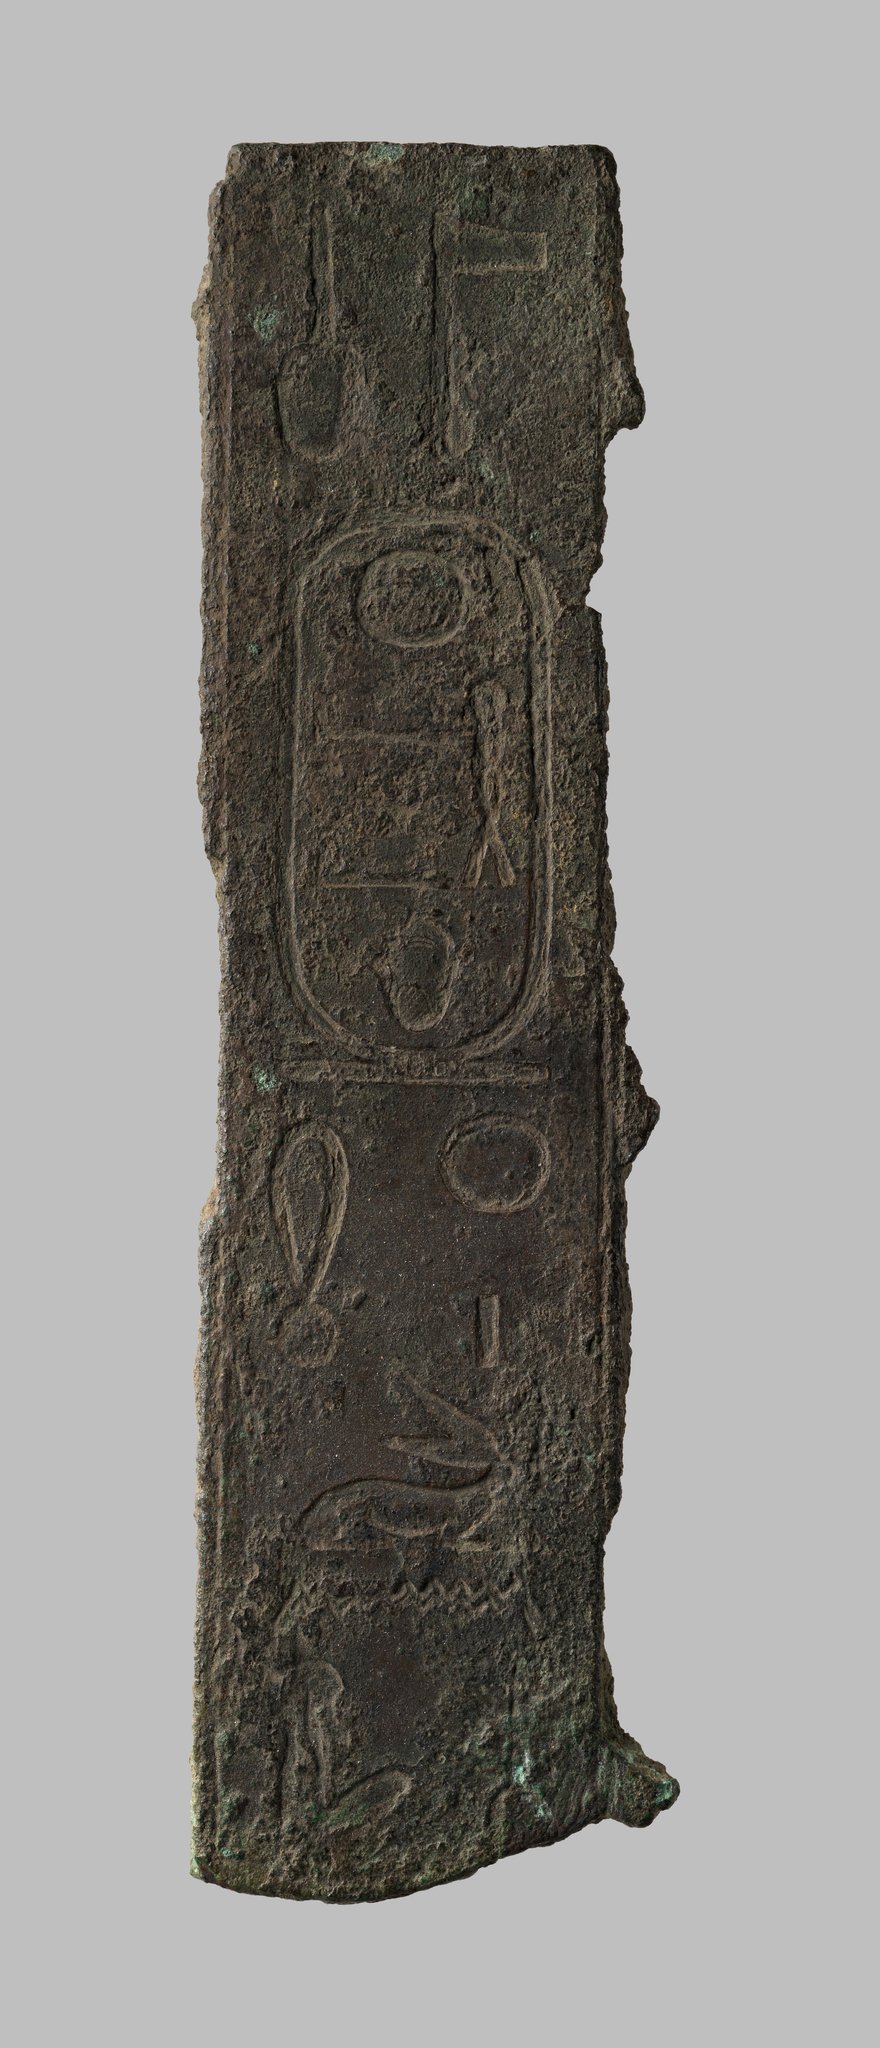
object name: shrine fragment, apries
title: Inscribed strip from shrine(?) with name of Apries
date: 589-570 BCE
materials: bronze, copper alloy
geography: egypt